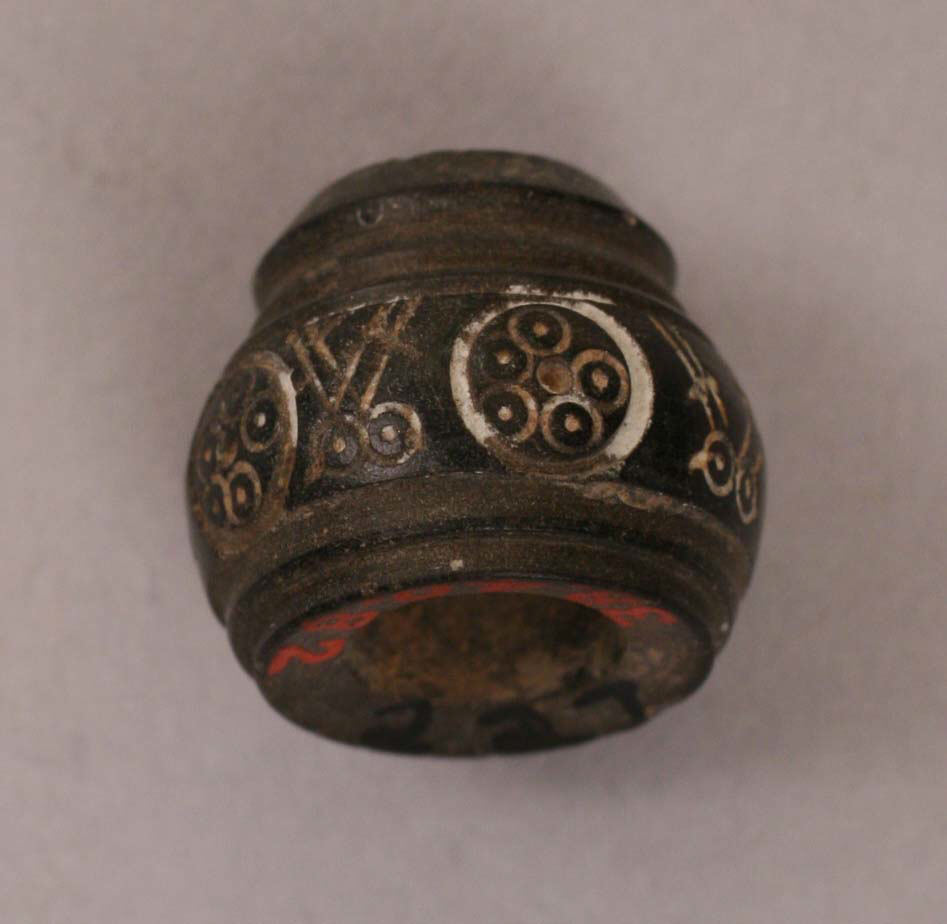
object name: button or bead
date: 701-1000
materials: stone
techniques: carving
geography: iran